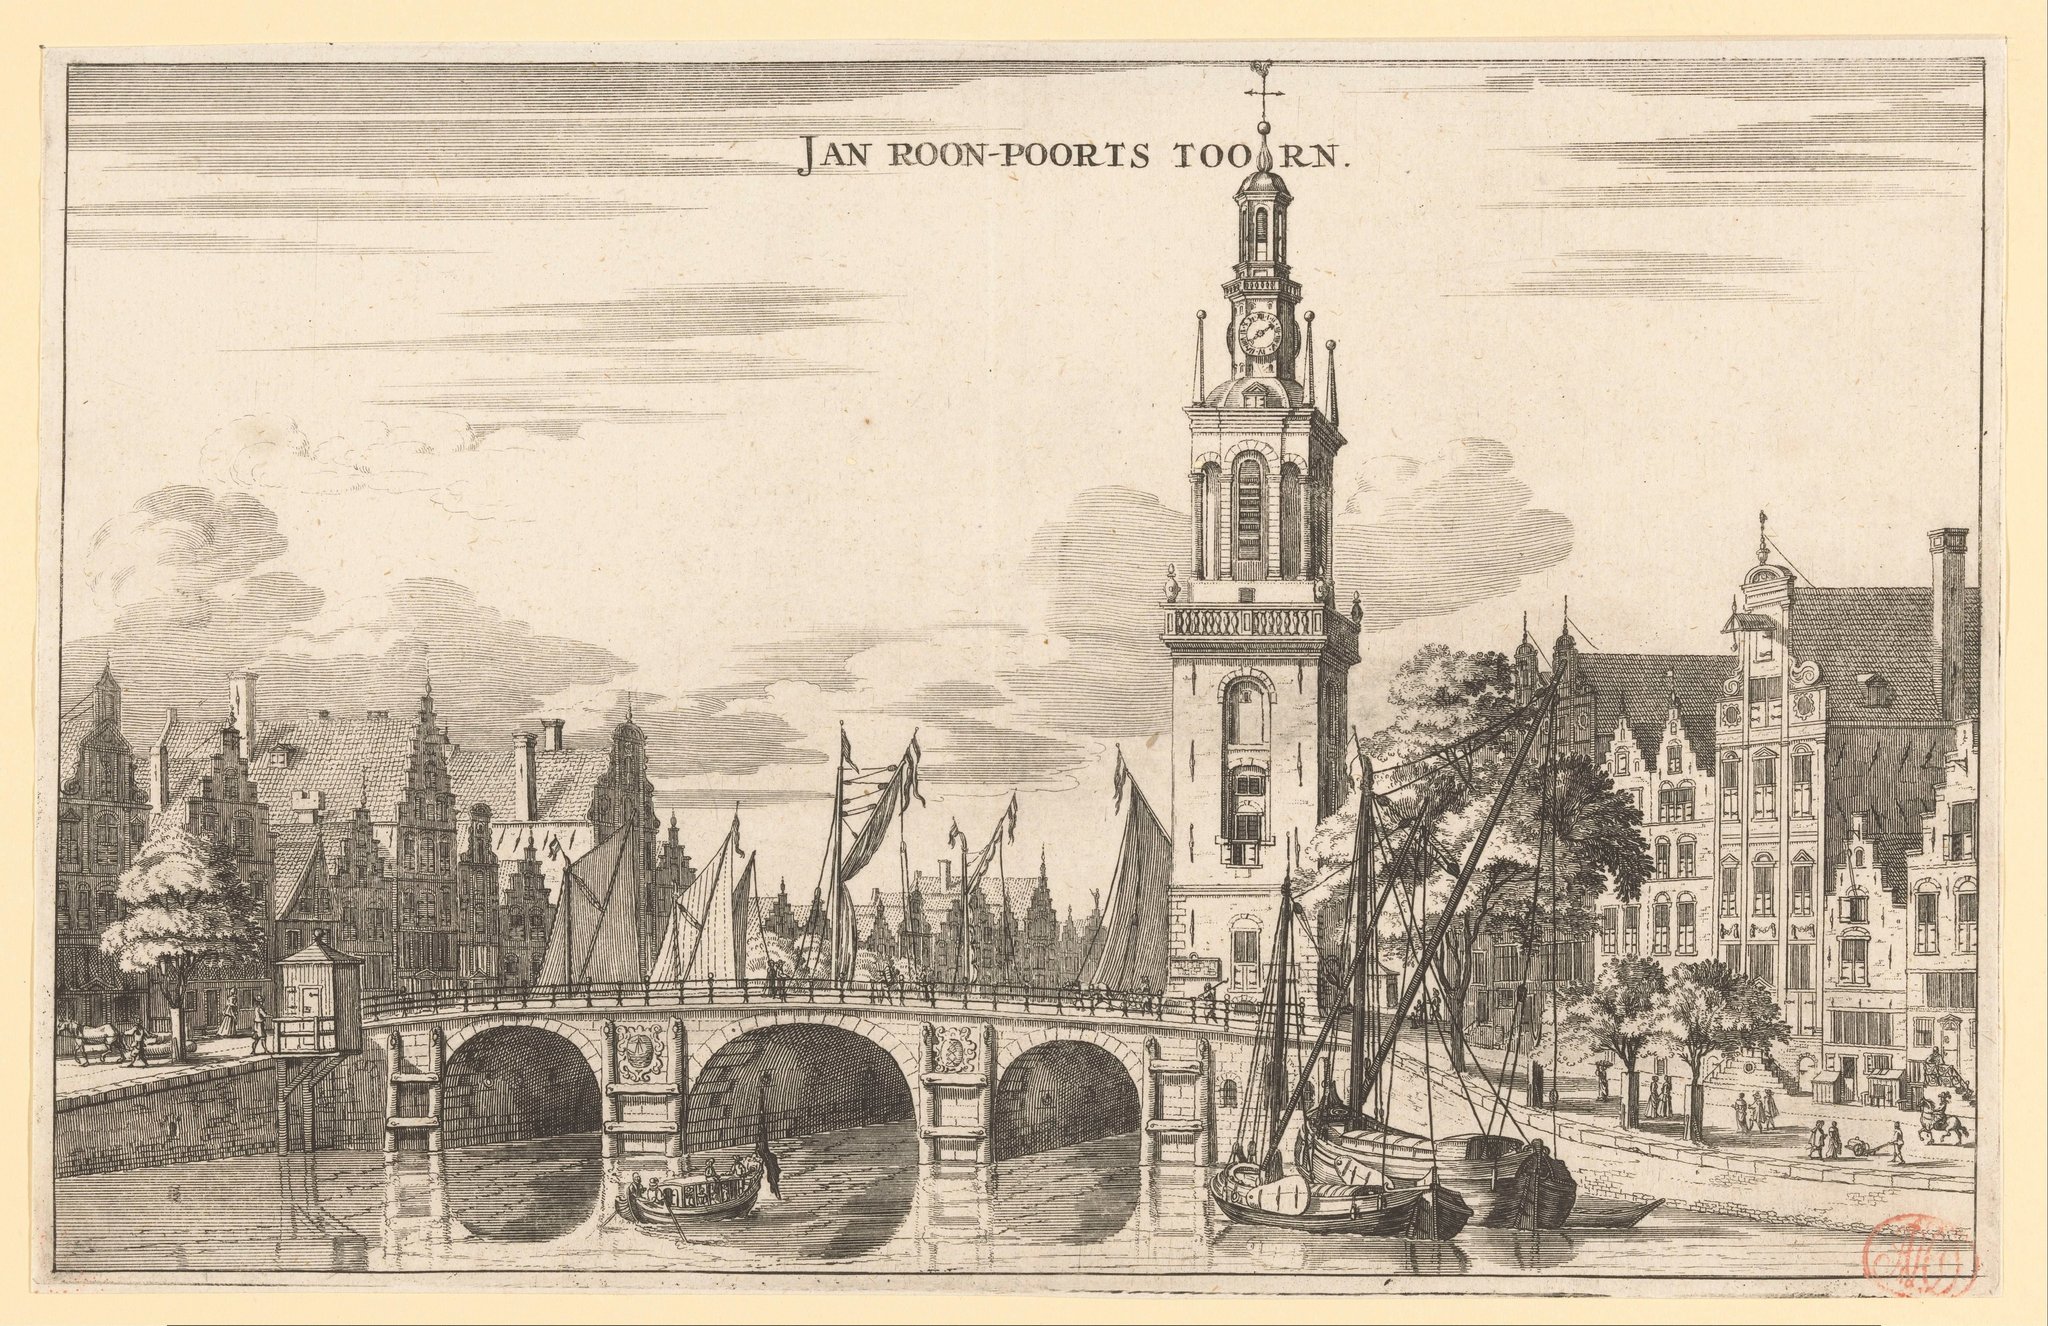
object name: print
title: Gezicht op de Jan Roodenpoortstoren te Amsterdam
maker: jacob van meurs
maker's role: draughtsman, print maker, publisher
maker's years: 1619-1680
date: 1663-1664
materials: paper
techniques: engraving, etching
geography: amsterdam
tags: bridge in city across river, canal, etc. (+ city(-scape) with figures, staffage), tower, clock tower ~ monumental adornment, canals, waters (in city) (+ city(-scape) with figures, staffage), street (+ city(-scape) with figures, staffage)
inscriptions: collector's mark: Lugt 195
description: Huidige staat van prent ook gebruikt in: Dapper, Olfert. Historische beschryving der stadt Amsterdam: waer in de voornaemste geschiedenissen (na een kort verhael van gansch Hollant en d'omleggende dorpen (…). Amsterdam: Jacob van Meurs, 1663.* En in: Zesen, Philipp von. Beschreibung der Stadt Amsterdam: darinnen von derselben ersten Ursprunge bis auf gegenwärtigen Zustand (…). Amsterdam: Joachim Nosche, 1664. * In sommige exemplaren van deze uitgave komt de huidige staat van de prent voor. In andere exemplaren is een latere staat ingebonden, waarop boven de Nederlandse een Franse titel is toegevoegd.